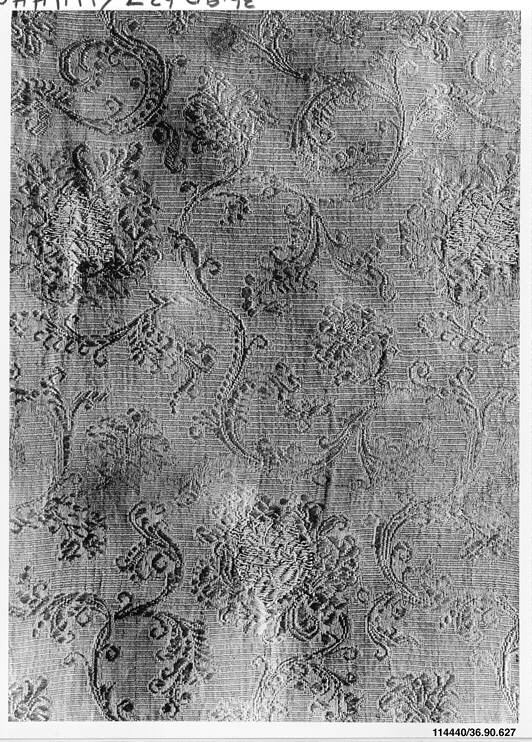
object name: piece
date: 1701-1800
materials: silk